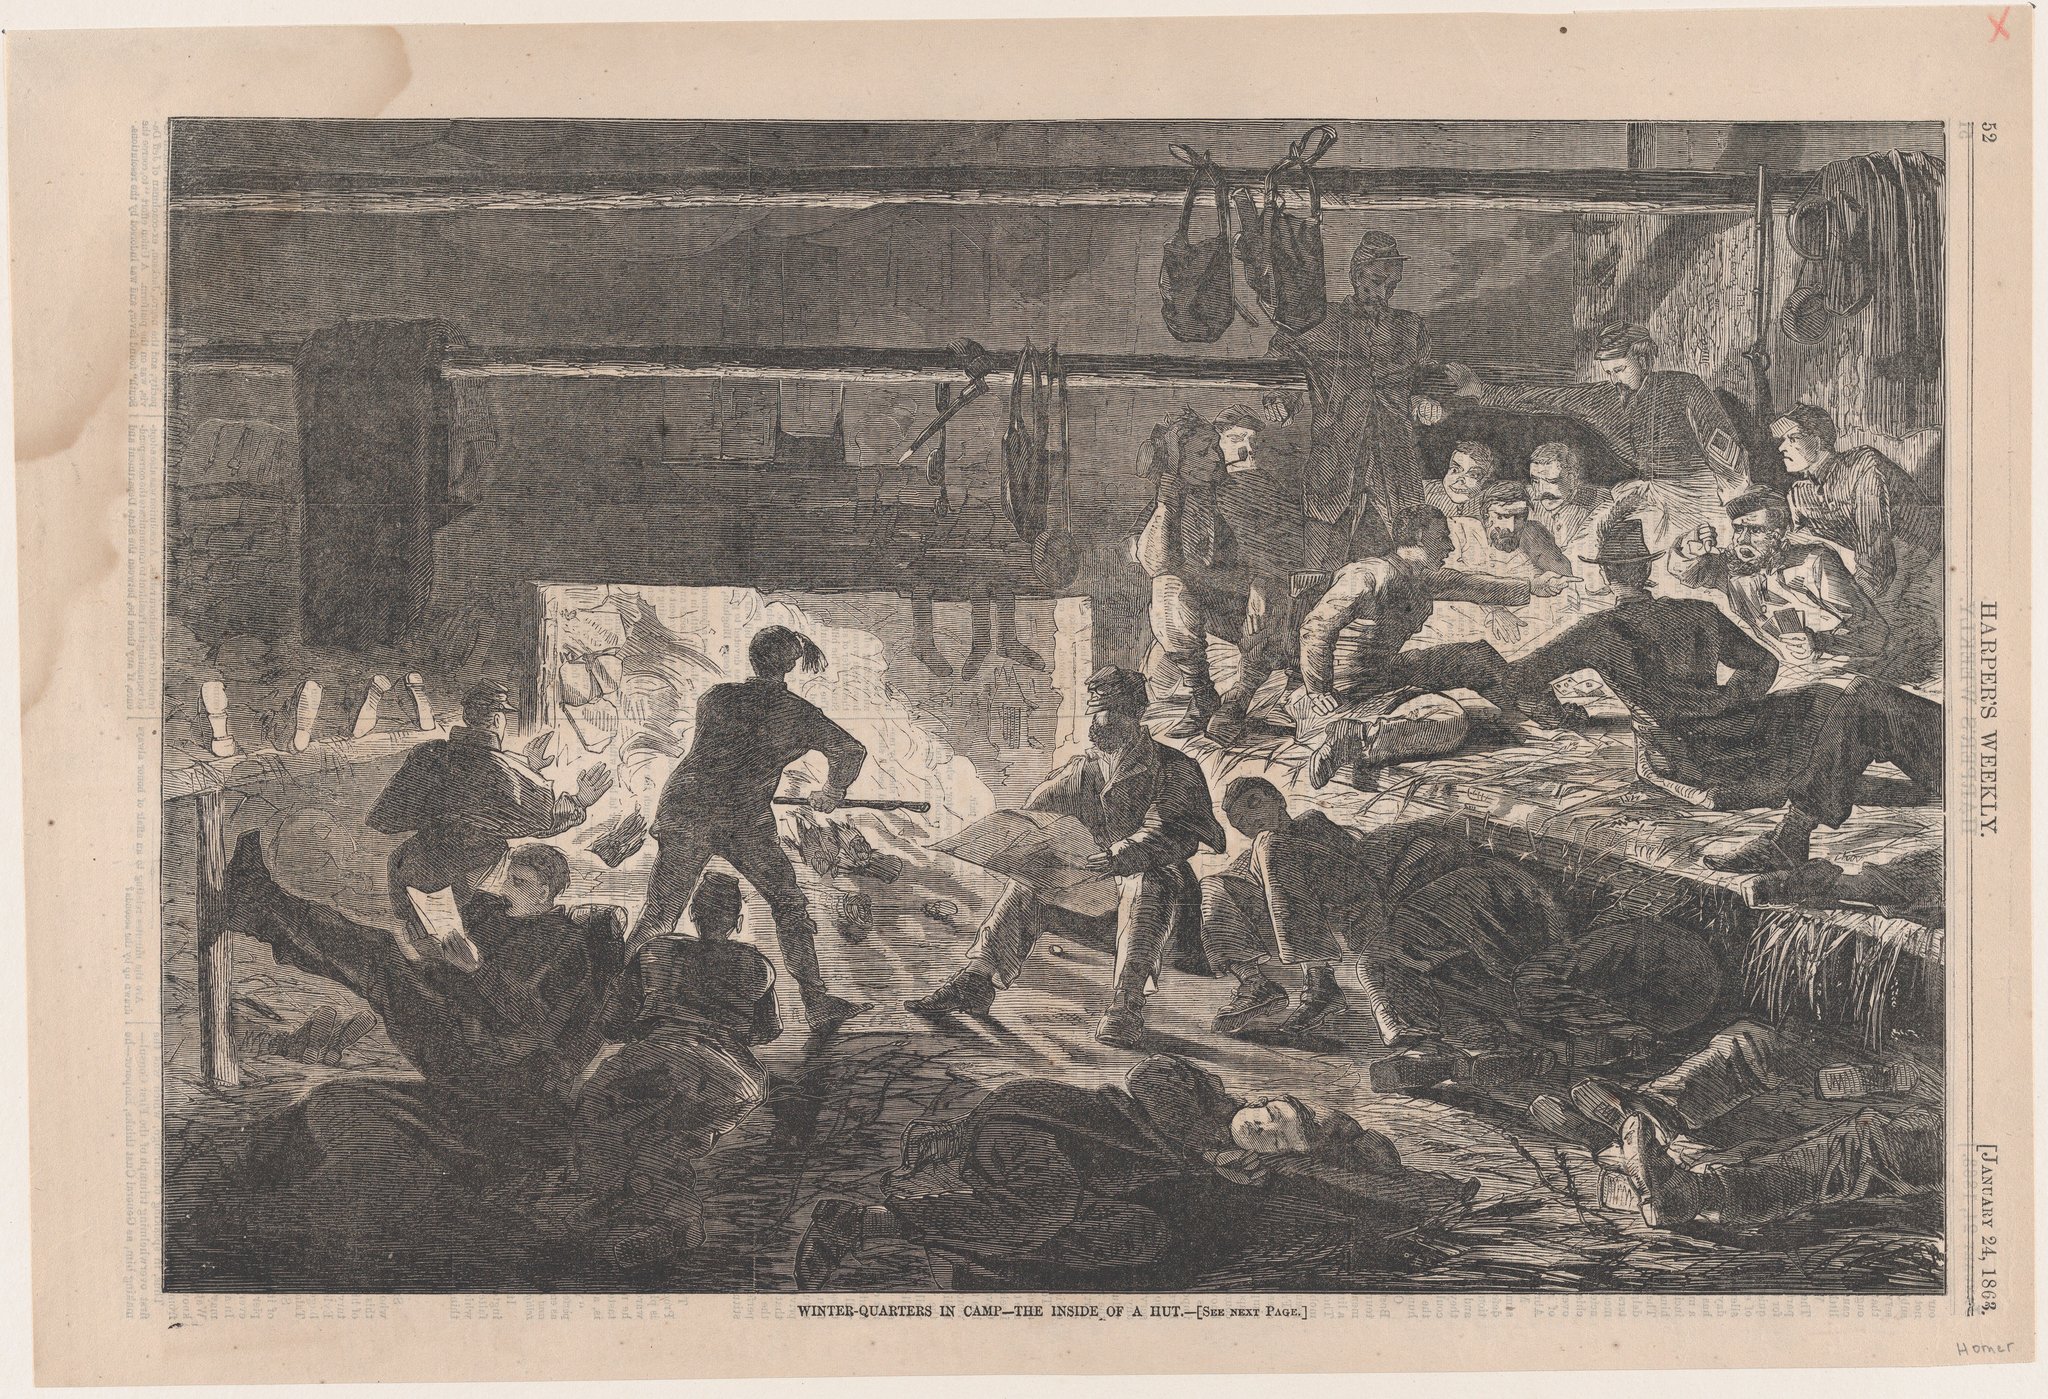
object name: print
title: Winter Quarters in Camp – The Inside of a Hut (from "Harper's Weekly," Vol. VII)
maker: winslow homer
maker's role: artist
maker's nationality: american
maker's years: 1836-1910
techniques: engraving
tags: soldiers,american civil war,men,fire,winter